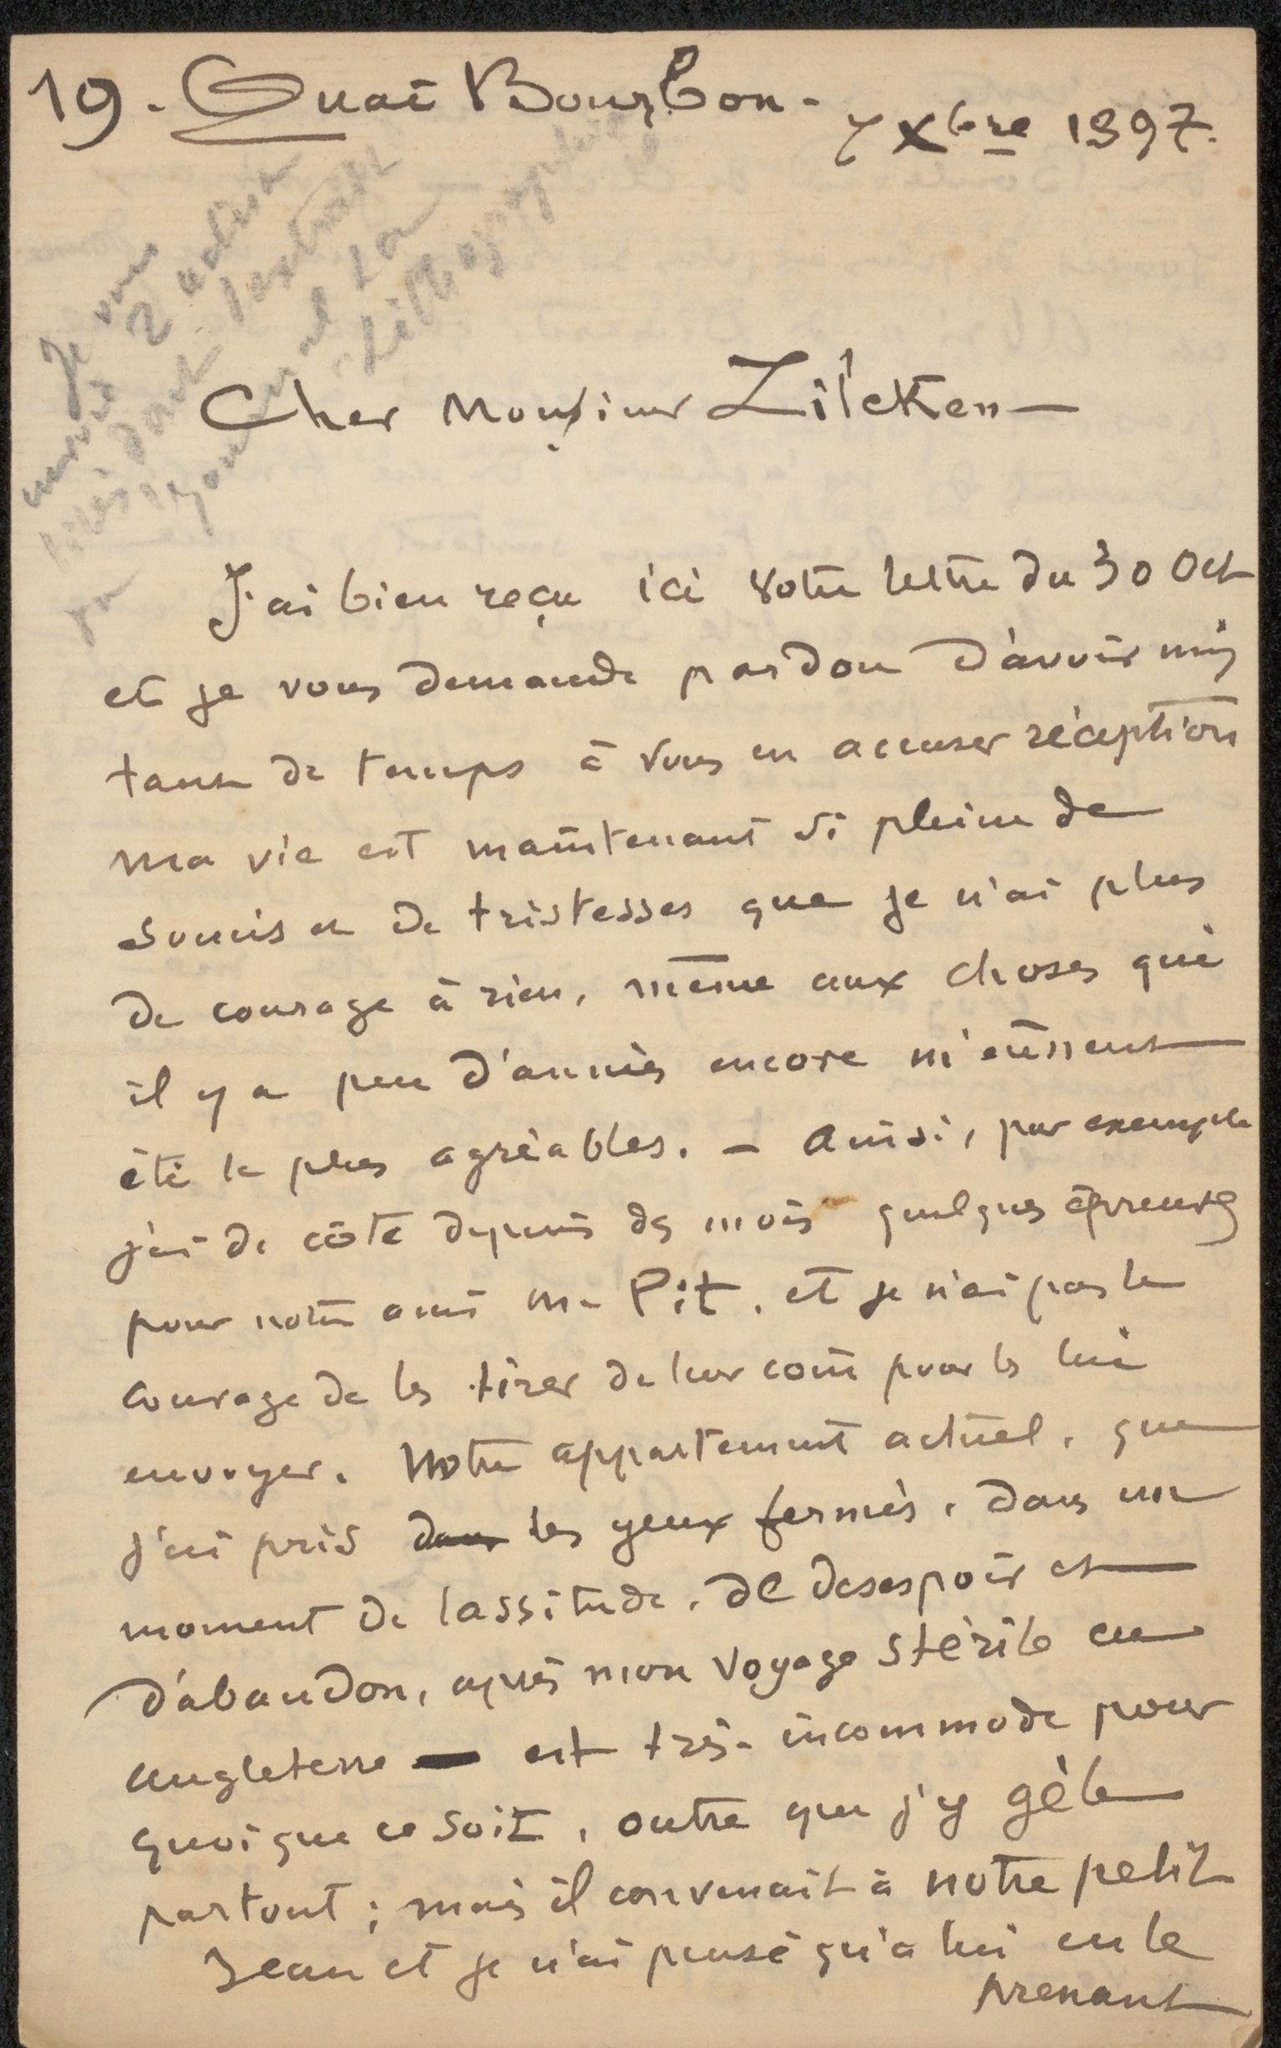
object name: letter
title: Brief aan Philip Zilcken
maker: félix hilaire buhot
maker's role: draughtsman, print maker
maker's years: 1847-1898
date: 1897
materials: chalk, ink, paper, pencil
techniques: pen, writing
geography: paris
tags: henri emile lefort, the hague, nijmegen, print maker, adriaan pit, paris, jean buhot, draughtsman, philip zilcken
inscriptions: collector's mark: ‘RPK’